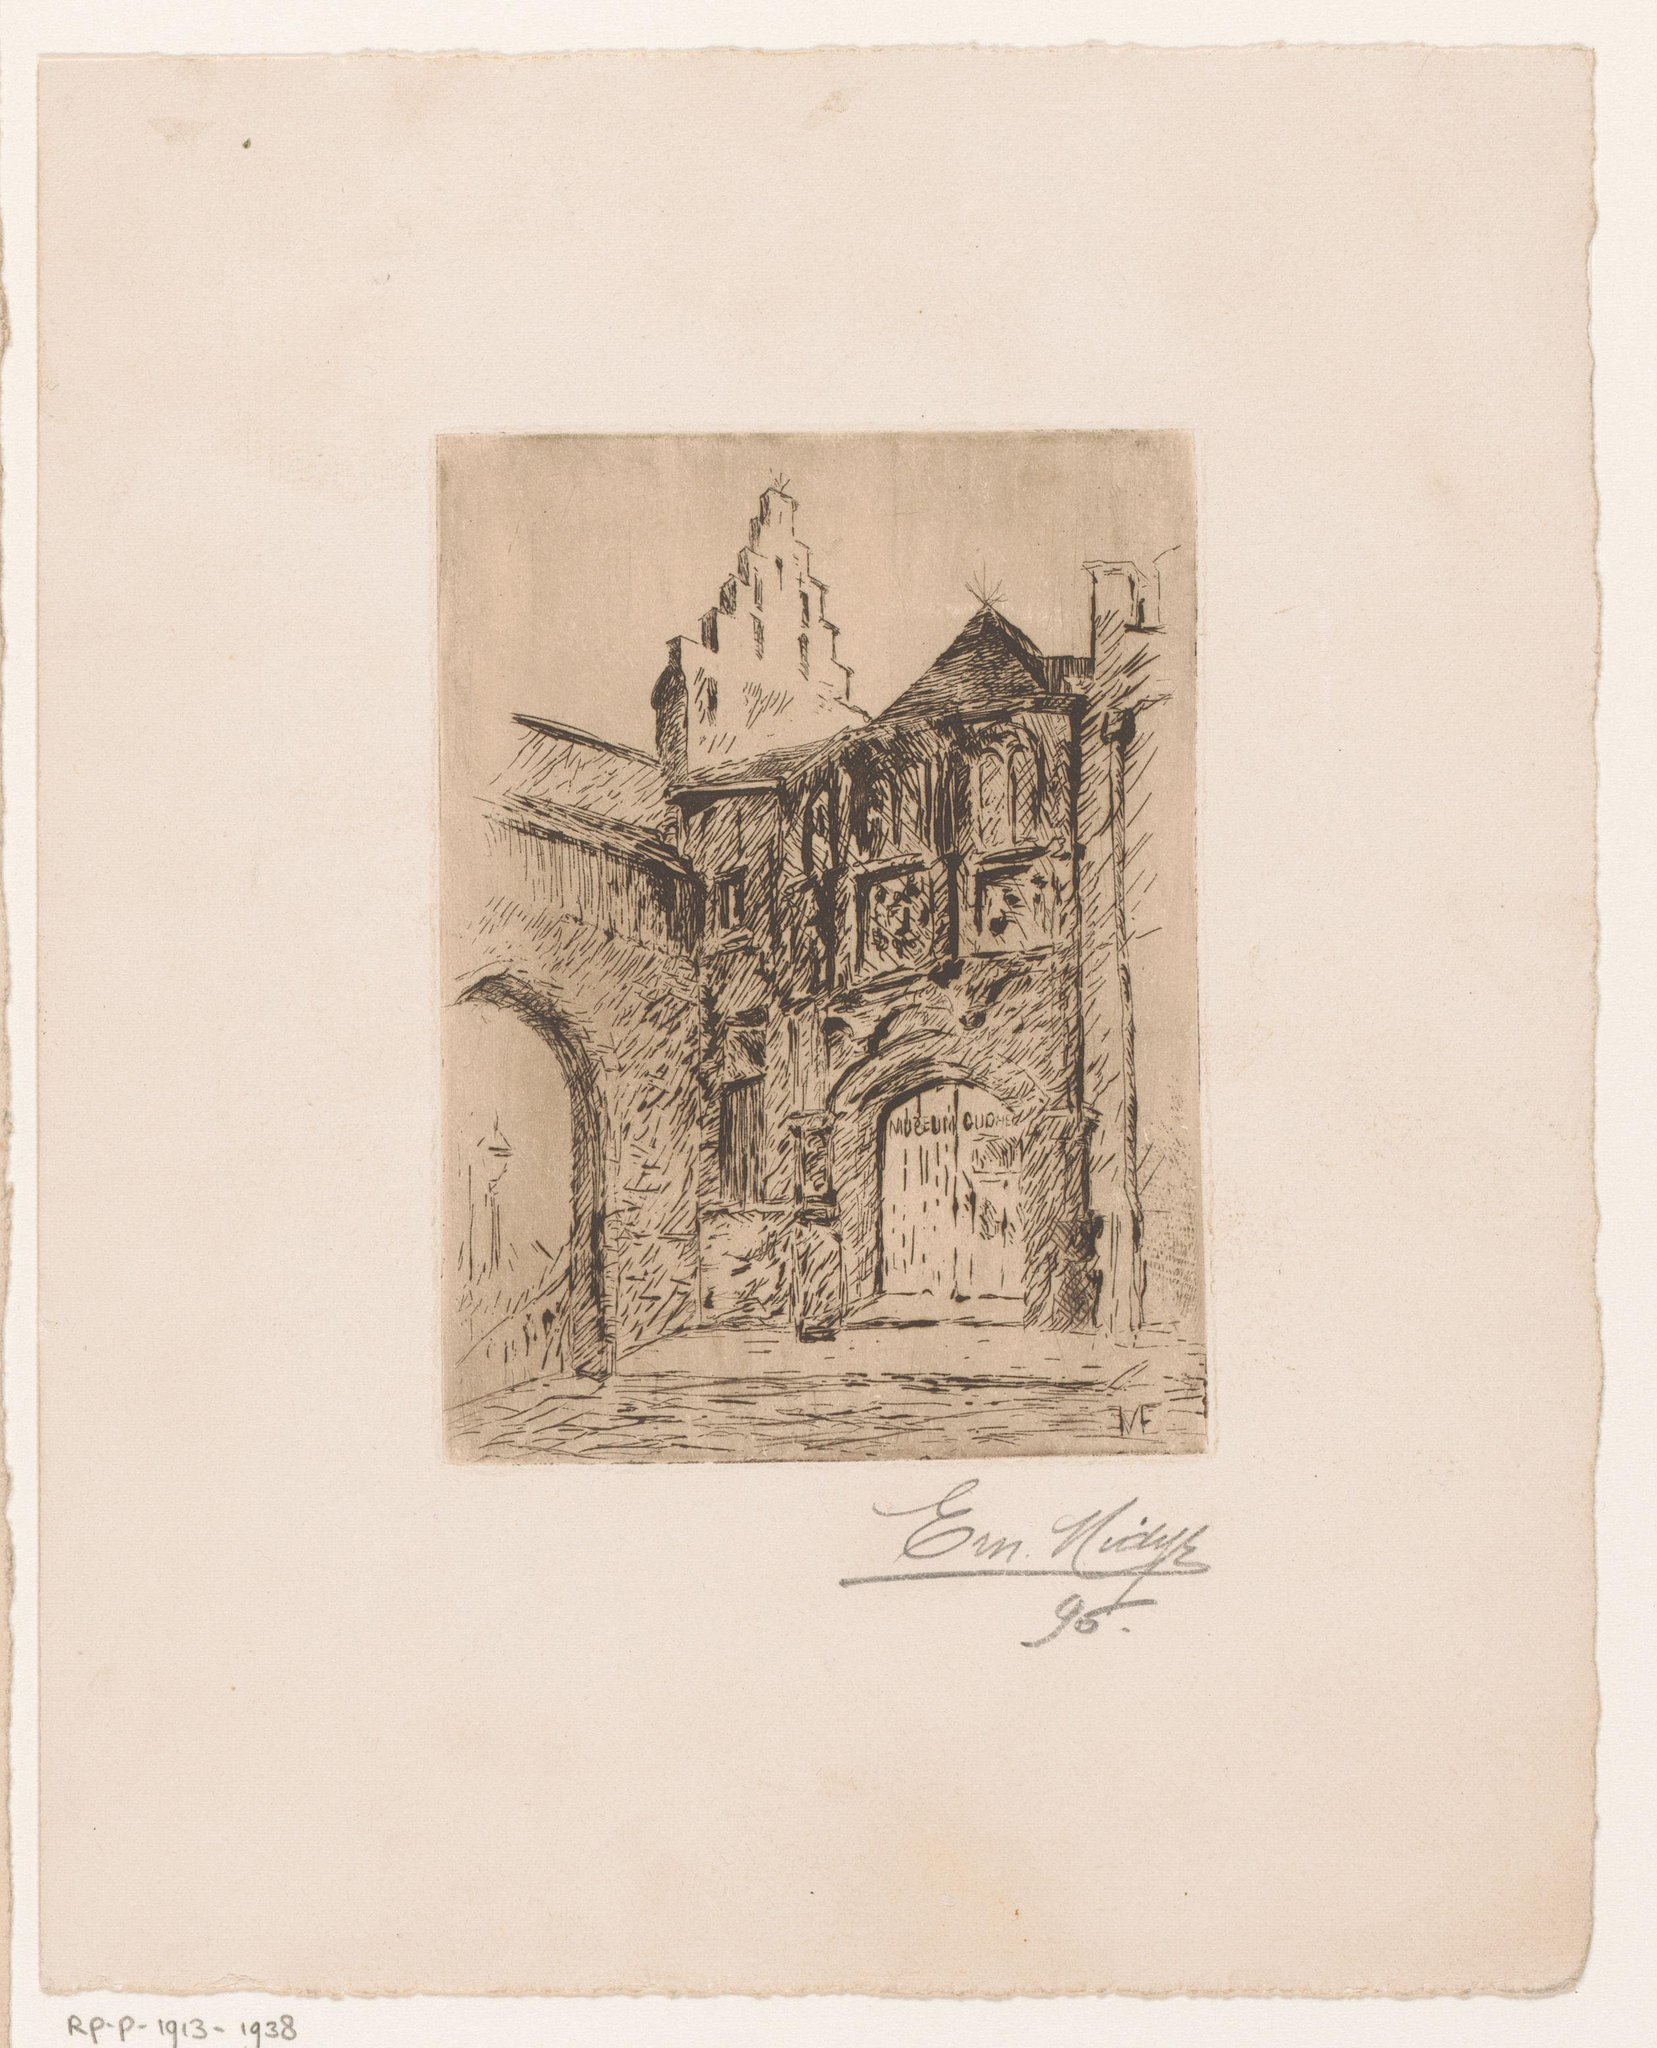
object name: print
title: Ingang van het museum van oudheden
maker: ernest midy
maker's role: print maker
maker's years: 1878-1938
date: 1895-1896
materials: paper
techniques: etching, intaglio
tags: permanent exhibition, museum, civic architecture; edifices; dwellings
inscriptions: collector's mark: Lugt 2228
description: Mogelijk gaat het om een gezicht op de museum ingang van Het Steen te Antwerpen.